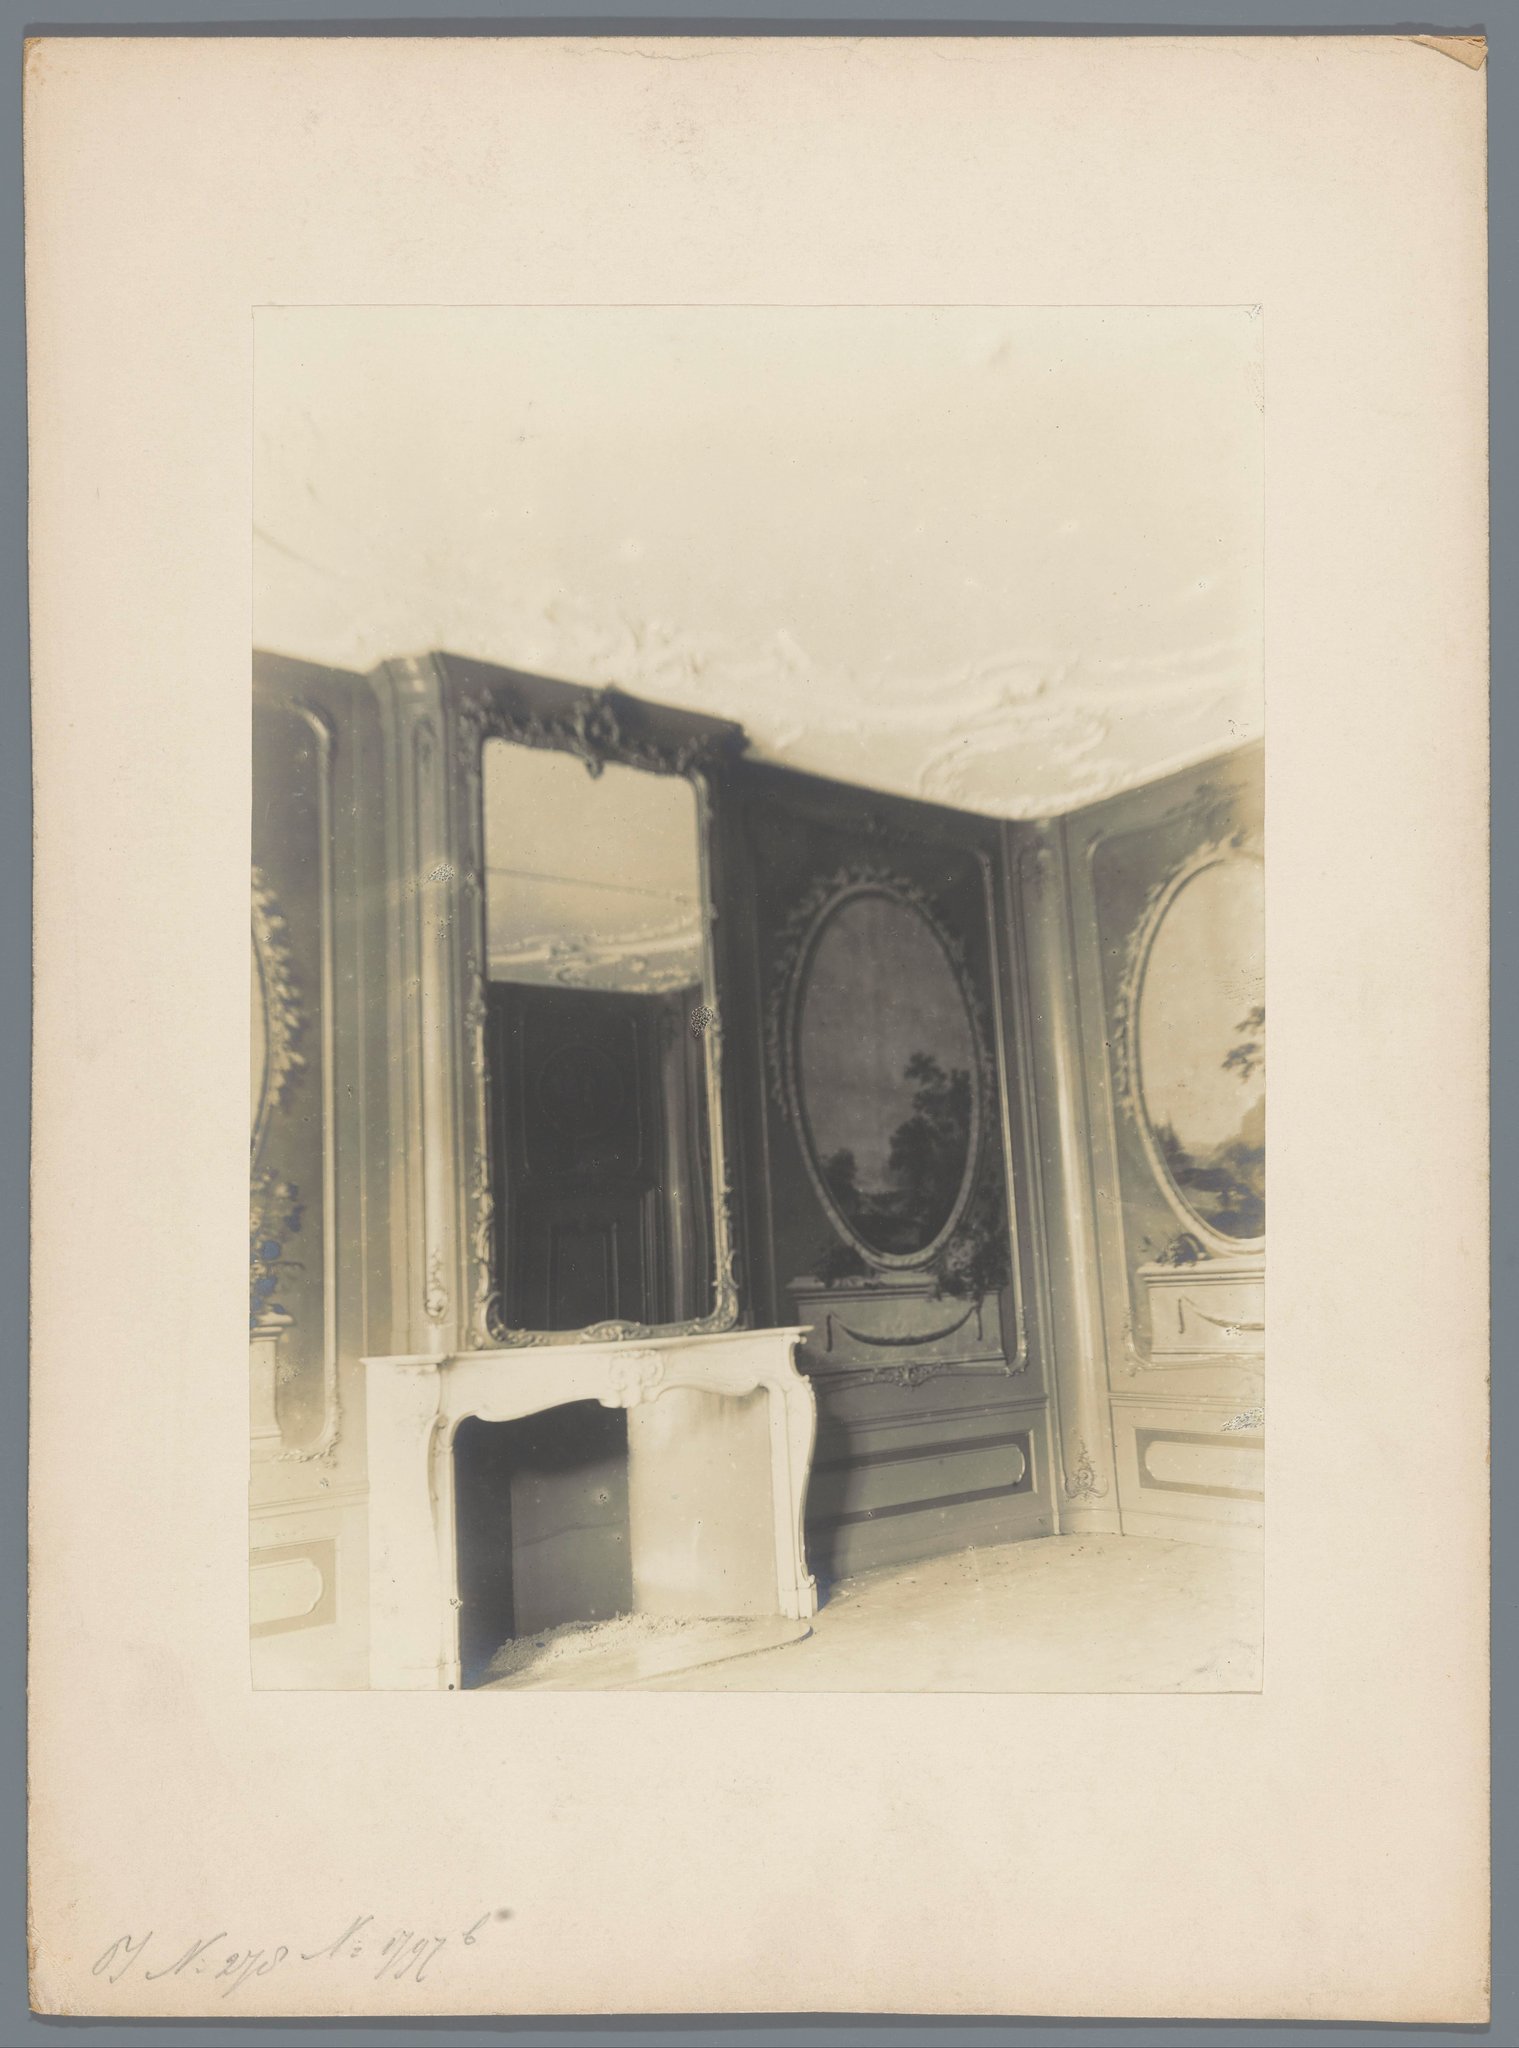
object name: photograph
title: Interieur met een schouw en een spiegel in het huis aan de Grote Houtstraat 39 te Haarlem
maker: Anonymous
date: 1900-1907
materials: cardboard, photographic support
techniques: gelatin silver print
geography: grote houtstraat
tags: mirror, open hearth, fire-place, interior of the house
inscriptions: inscription: ‘Haarlem, N. H. Huis Groote Houtstraat 39 verbouwd Juli 1907.’, annotation, inscription: ‘neg. no 15255 foto 7484’